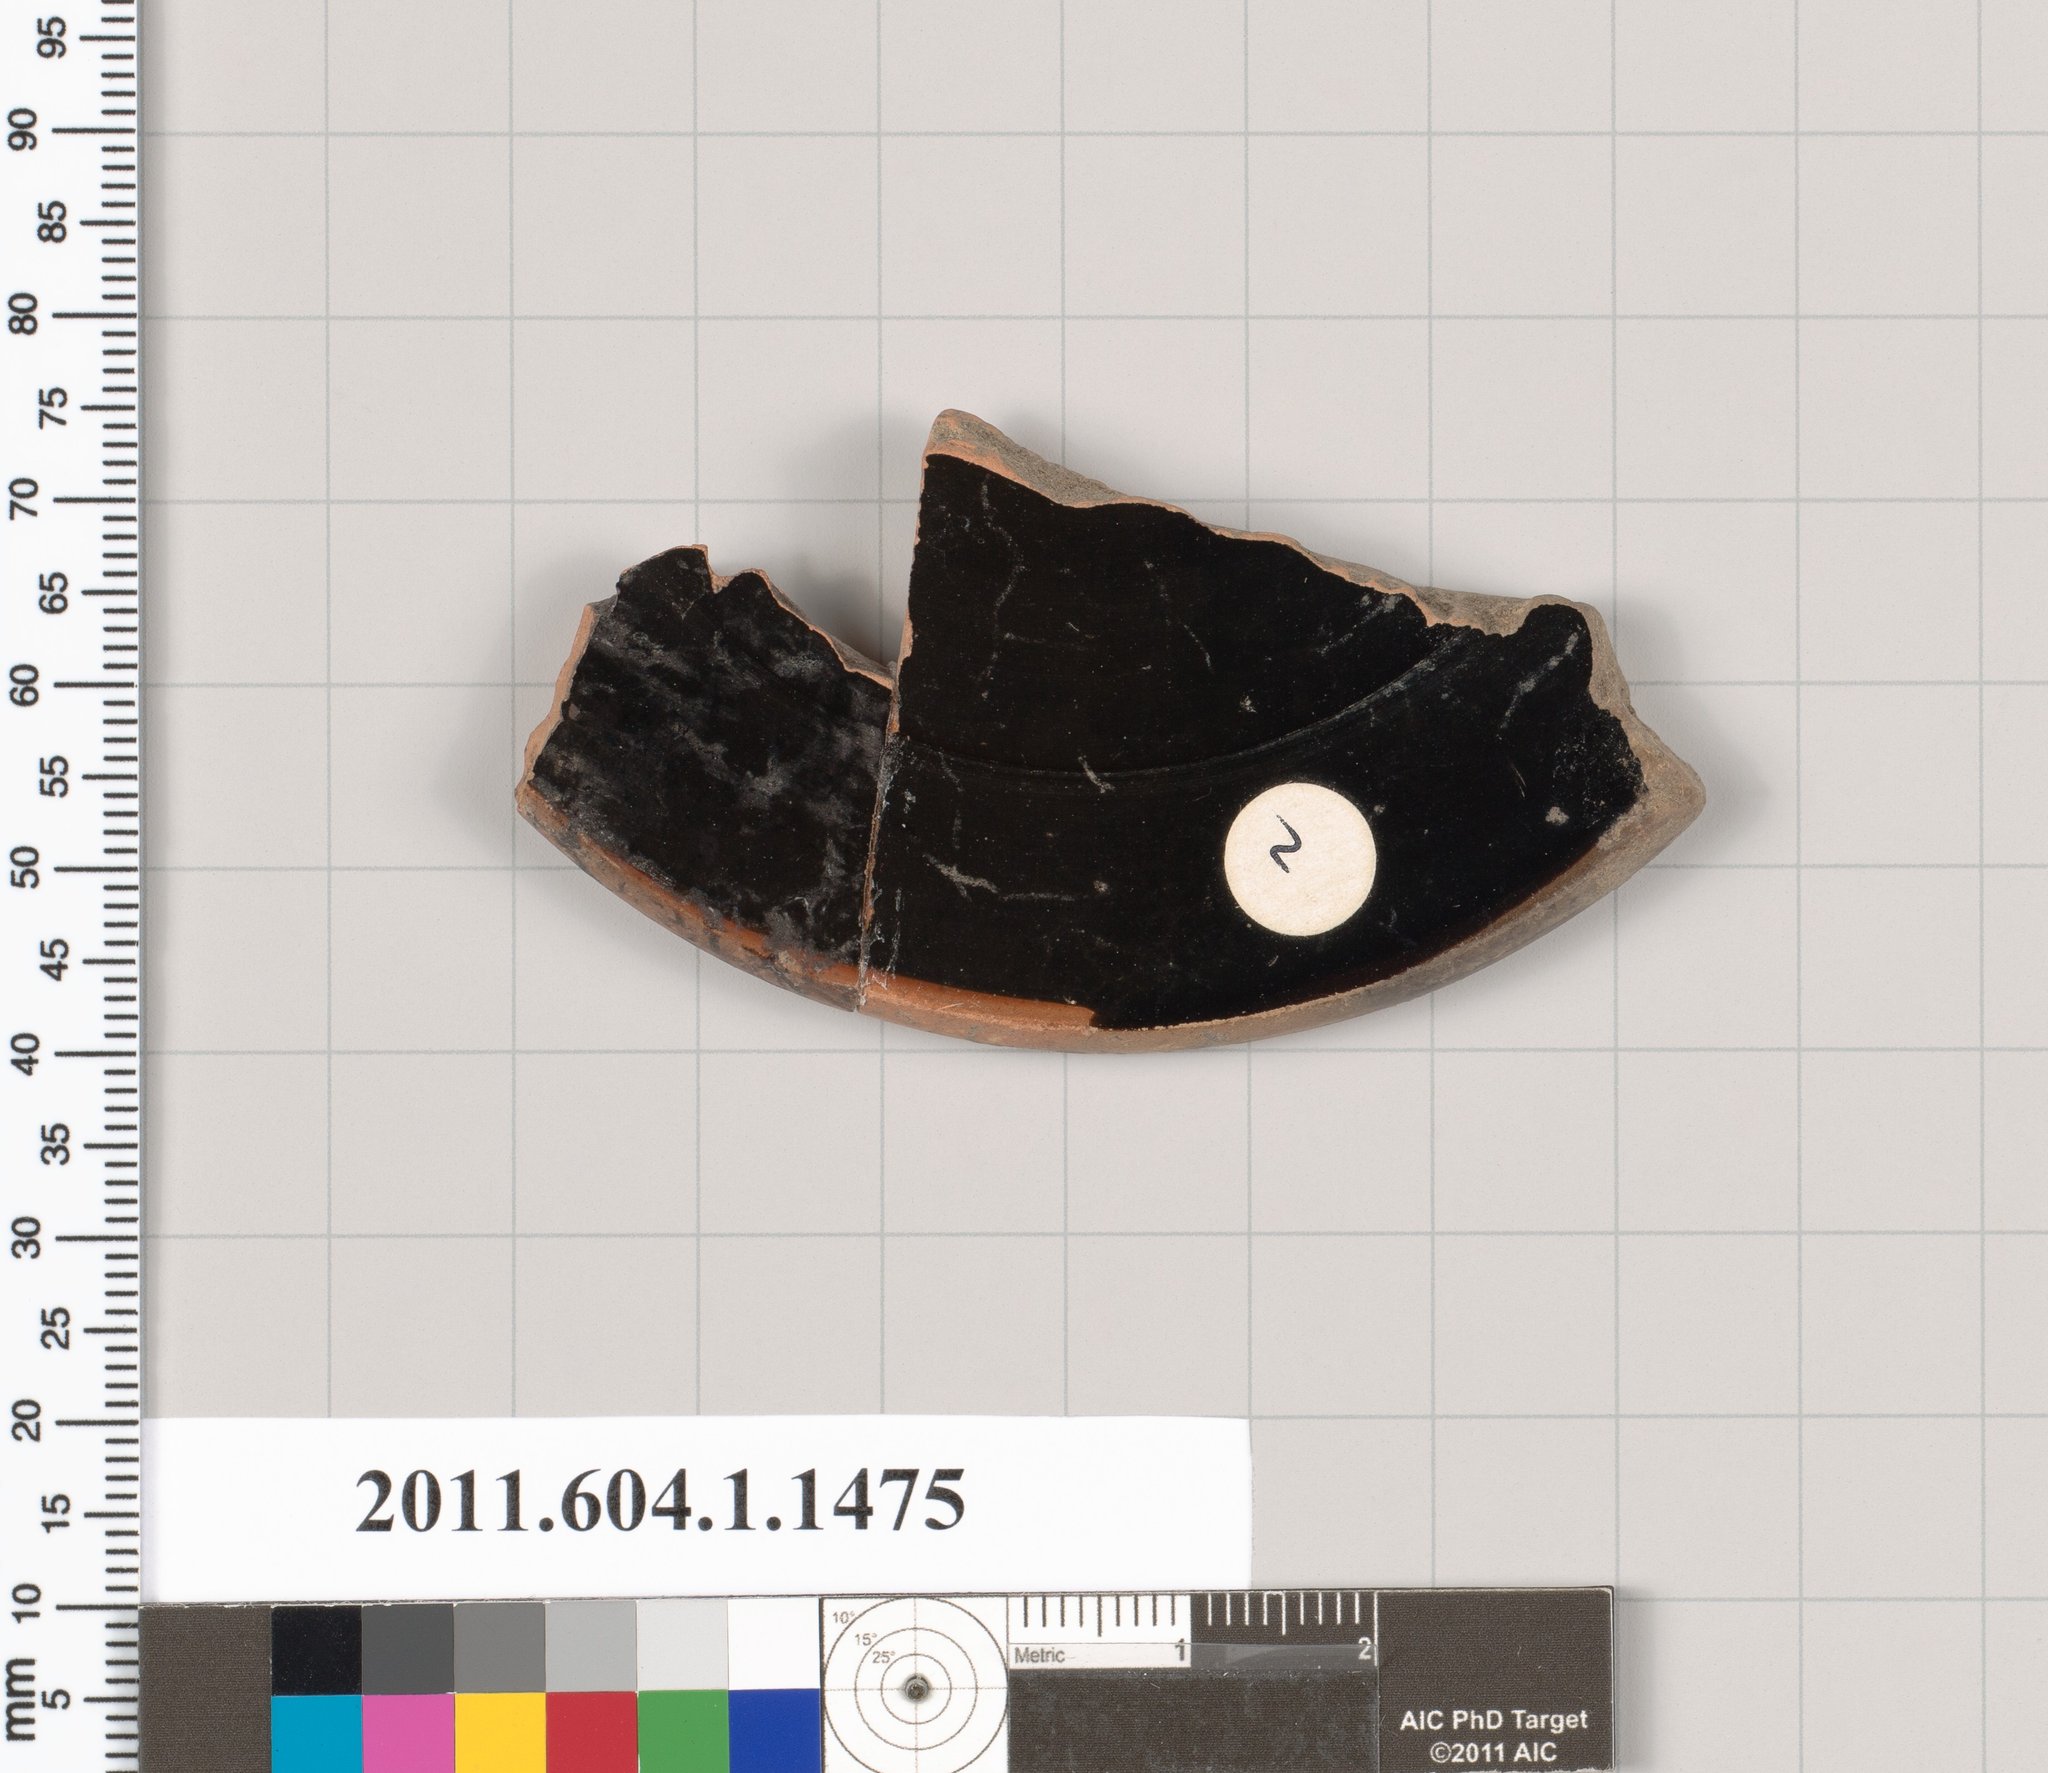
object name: kylix fragment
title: Terracotta fragment of a kylix (drinking cup)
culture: greek, attic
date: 500-401 BCE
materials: terracotta